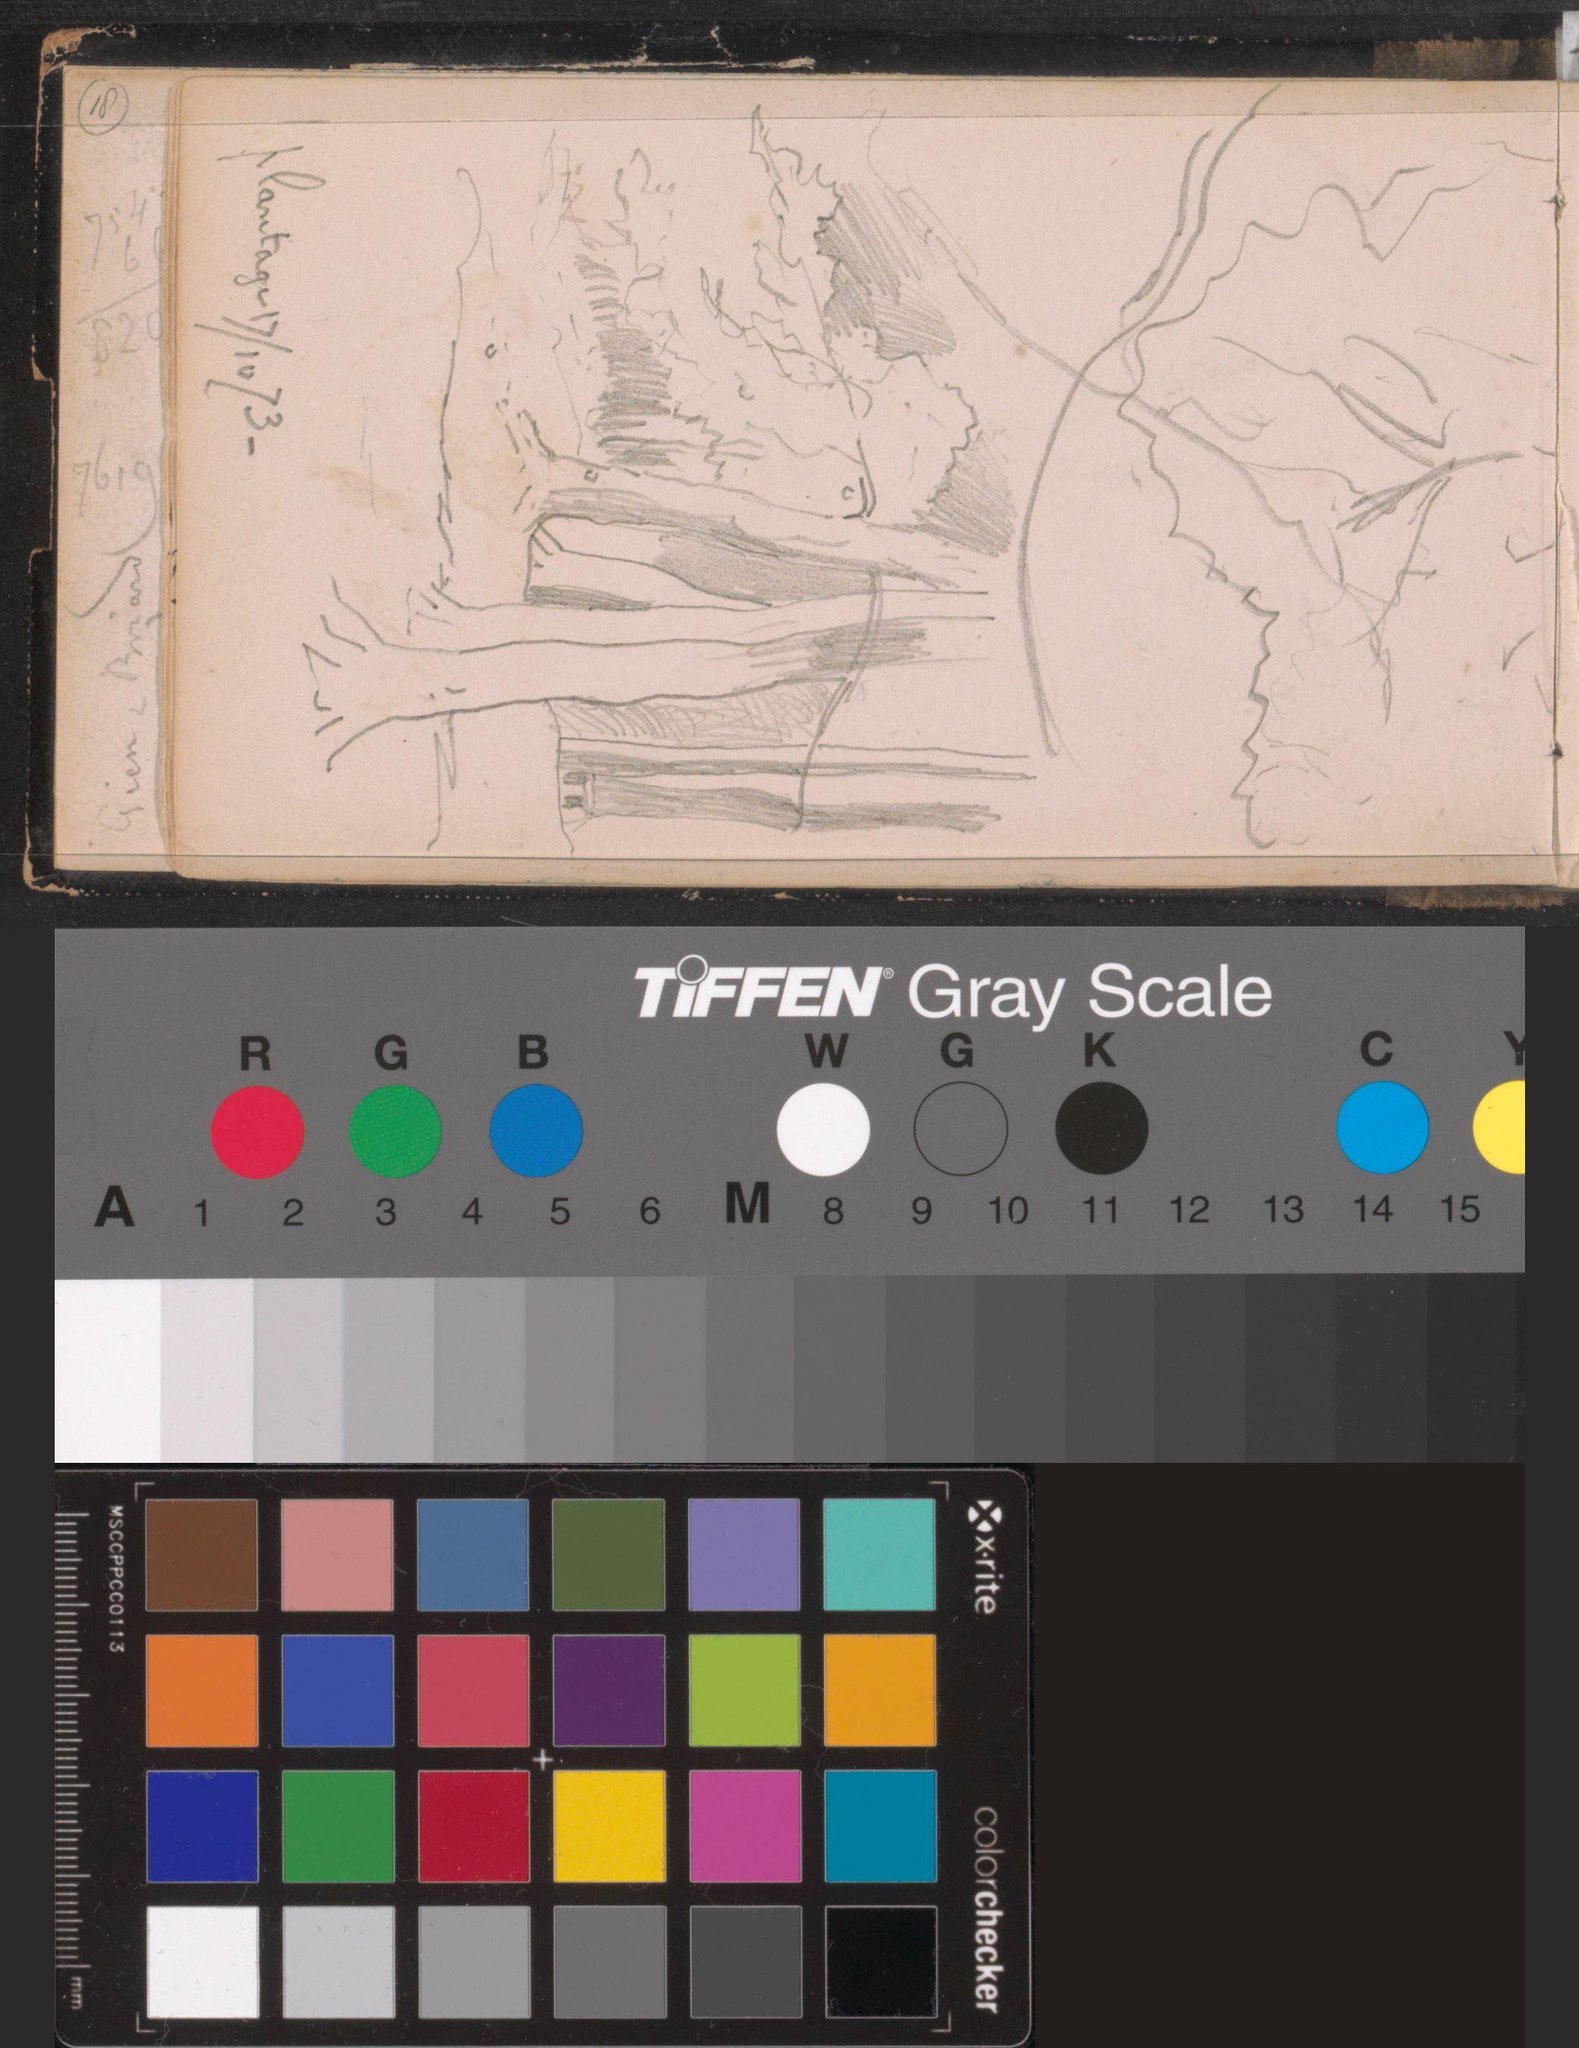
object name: sketchbook leaf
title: Bos bij de Plantage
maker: johannes tavenraat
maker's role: draughtsman, painter, print maker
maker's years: 1809-1881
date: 1810-1873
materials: paper, pencil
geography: south holland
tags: forest, wood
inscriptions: date and inscription: ‘plantage 17/10/73-’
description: Blad 5 recto uit een schetsboek met 46 bladen.